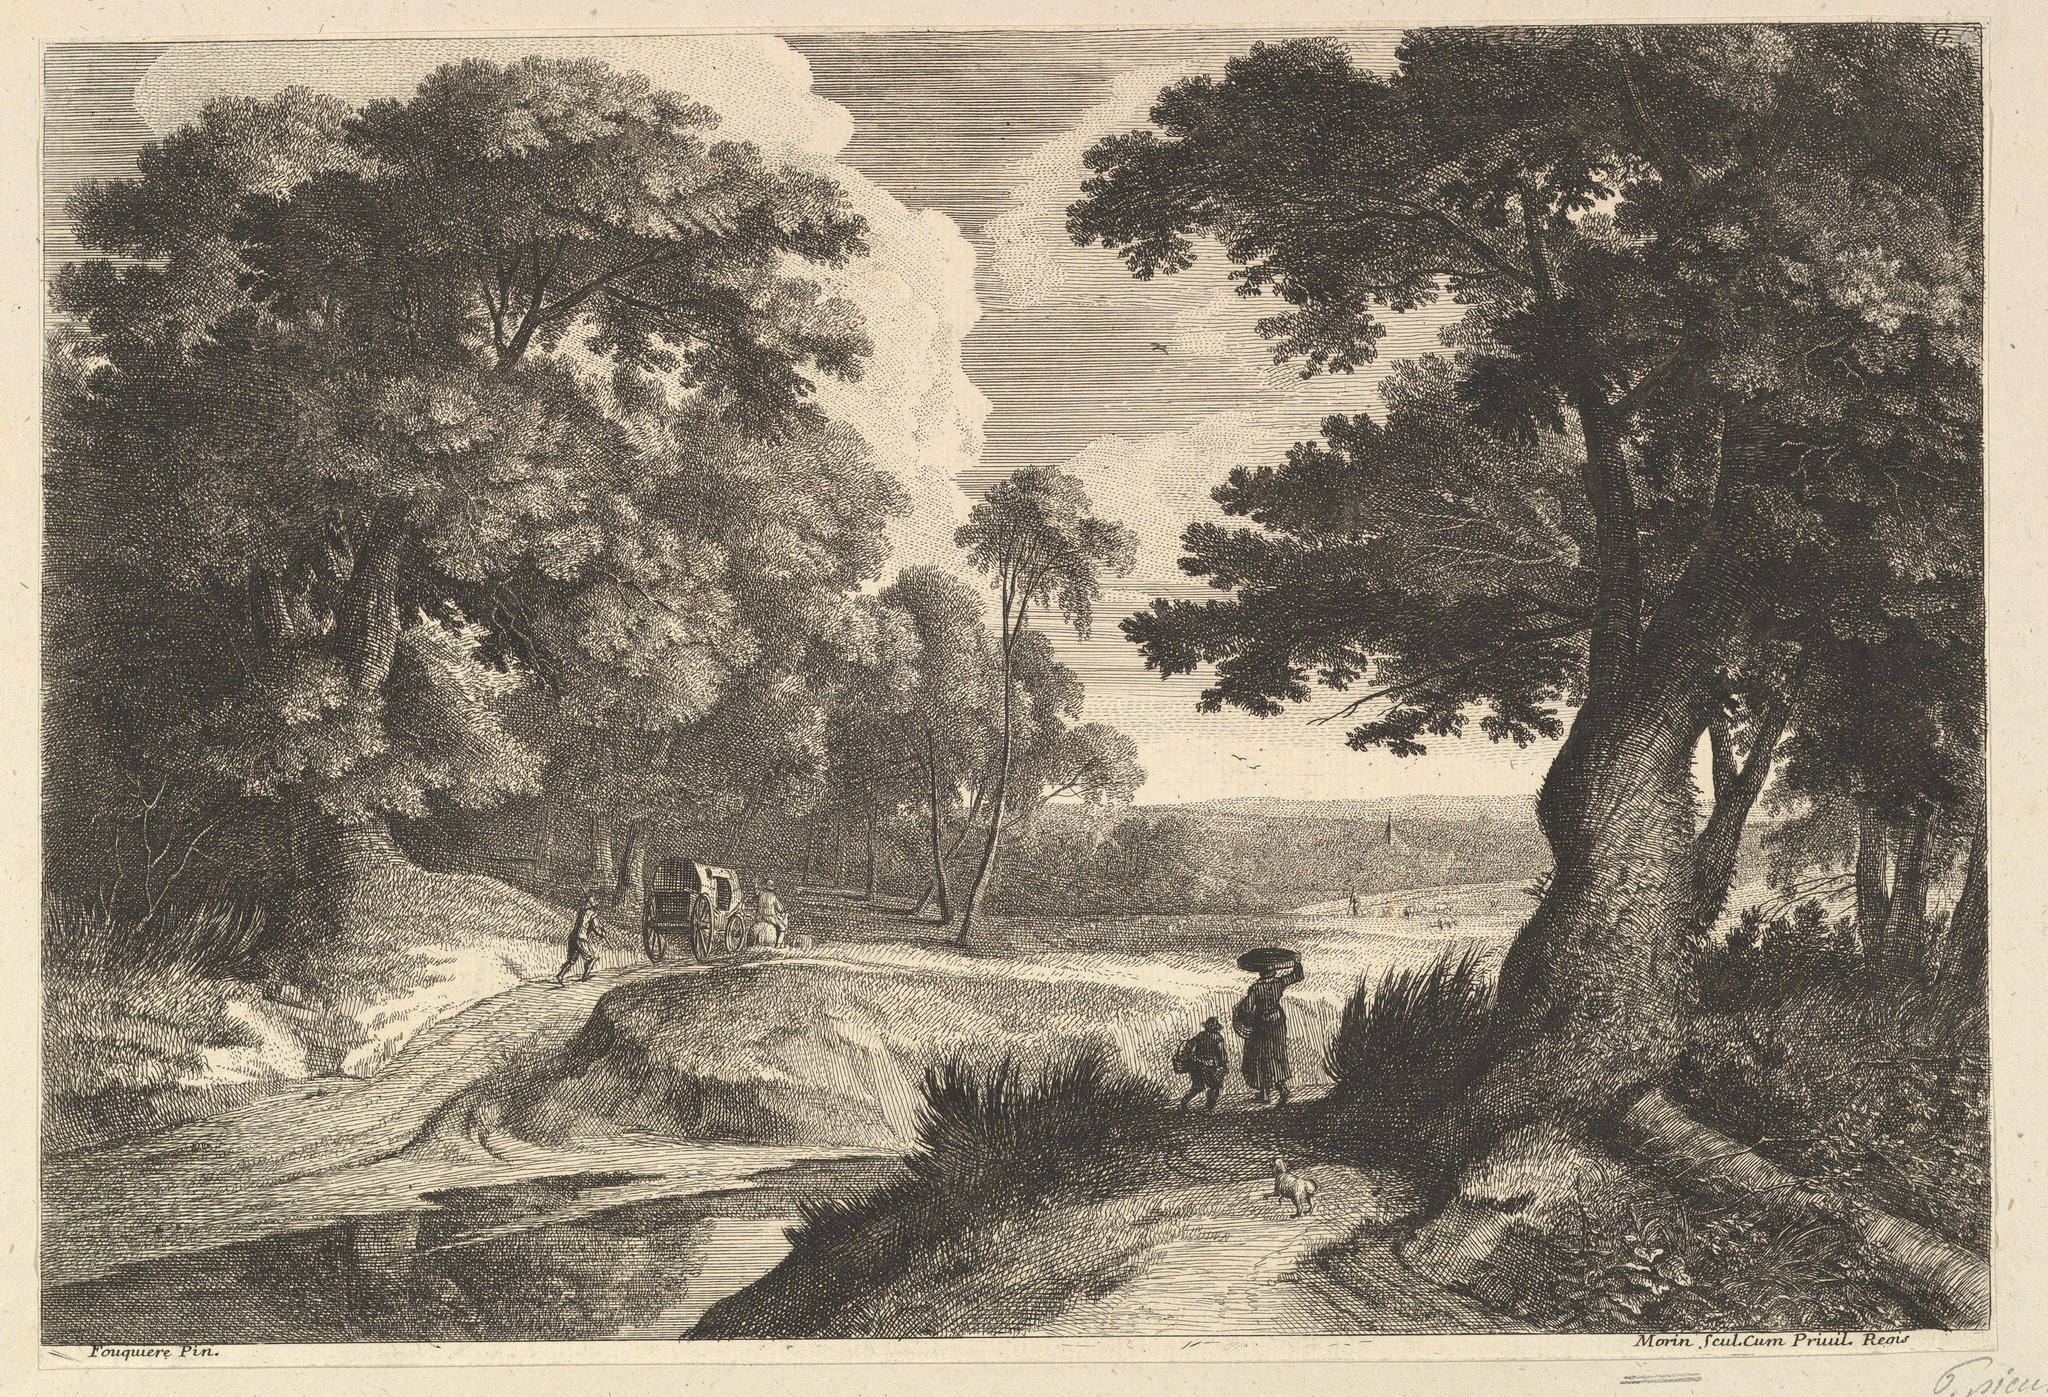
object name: print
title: La Paysanne en Marche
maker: jean morin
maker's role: artist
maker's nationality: french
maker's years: 1605-1650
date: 1605-1650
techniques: etching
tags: landscapes,trees